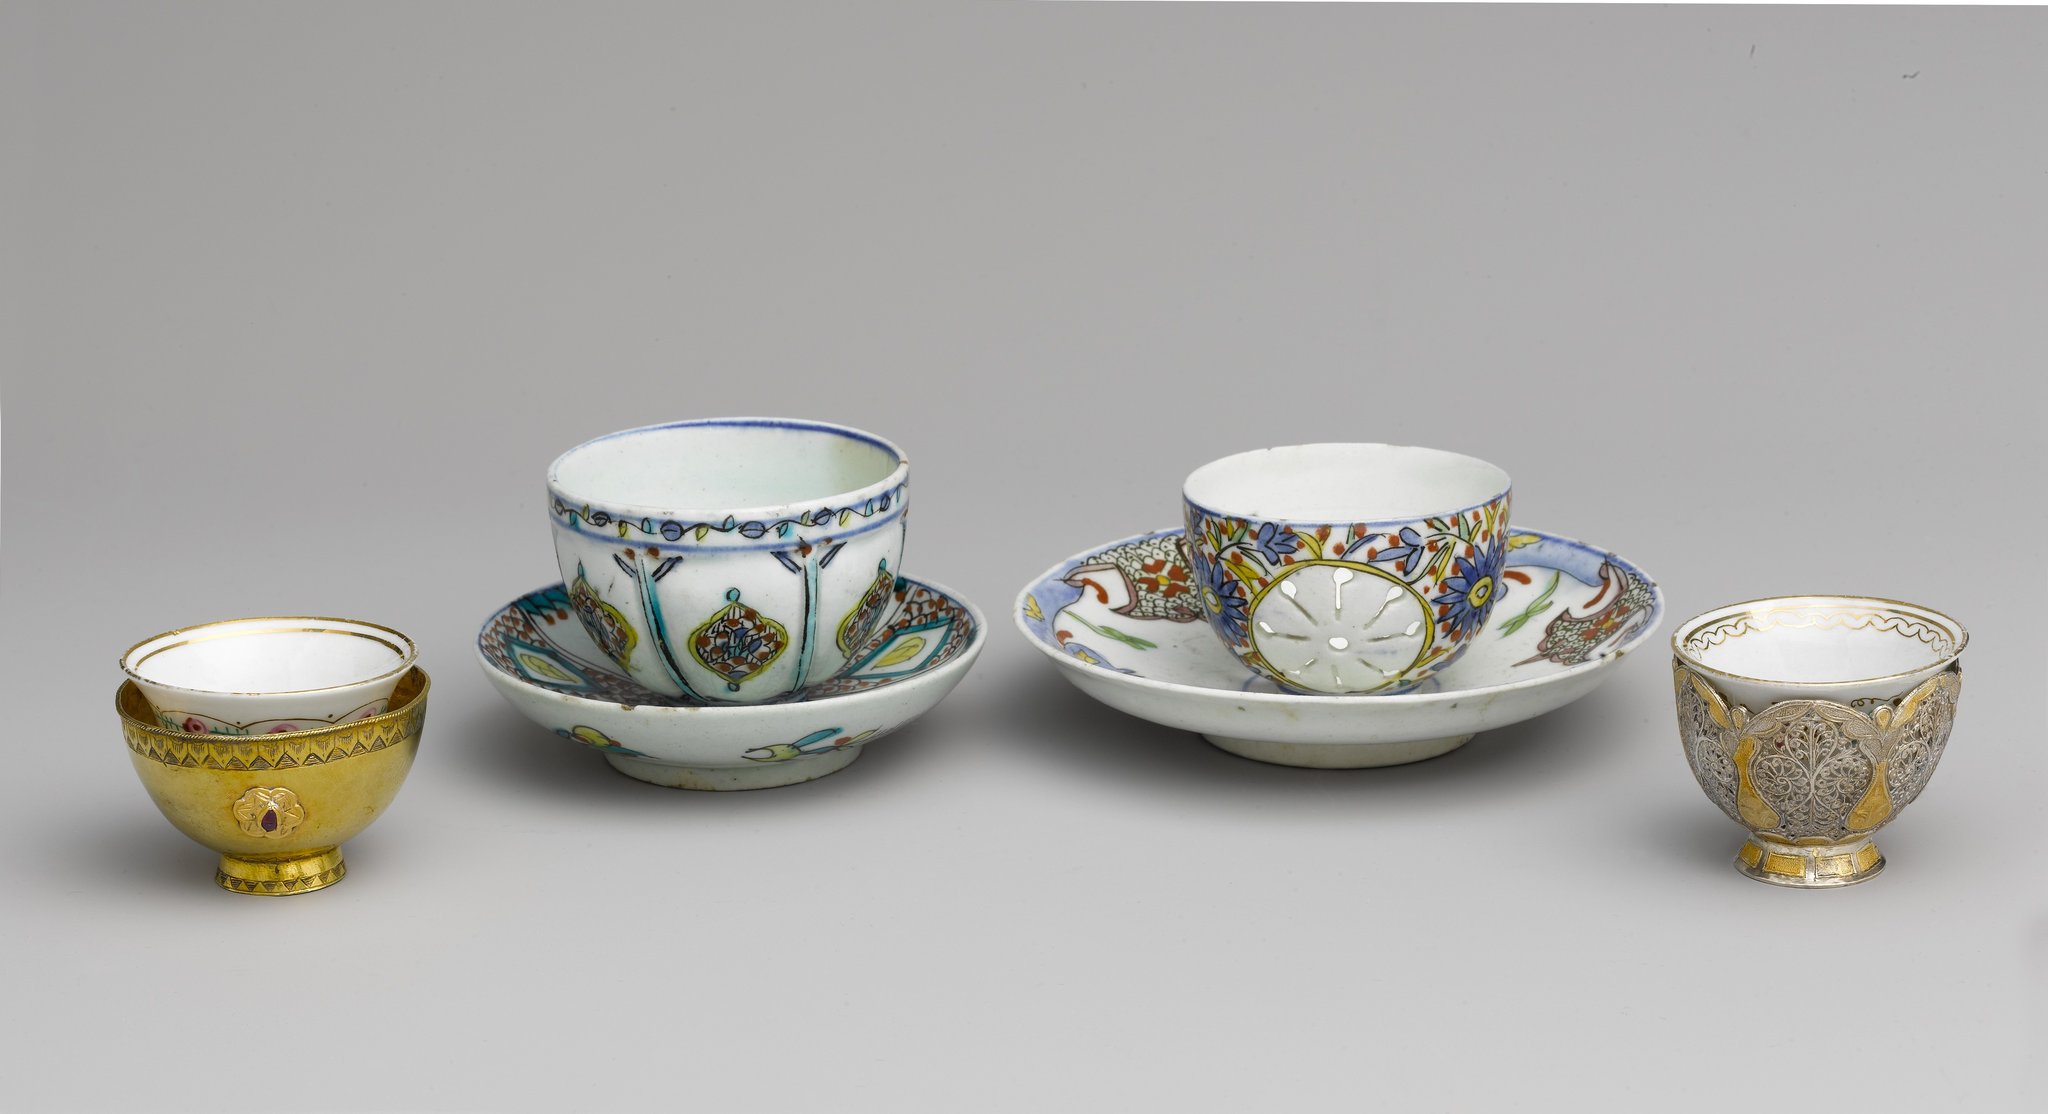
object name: cup holder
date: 1701-1800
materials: glaze, stonepaste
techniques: painting, polychrome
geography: turkey